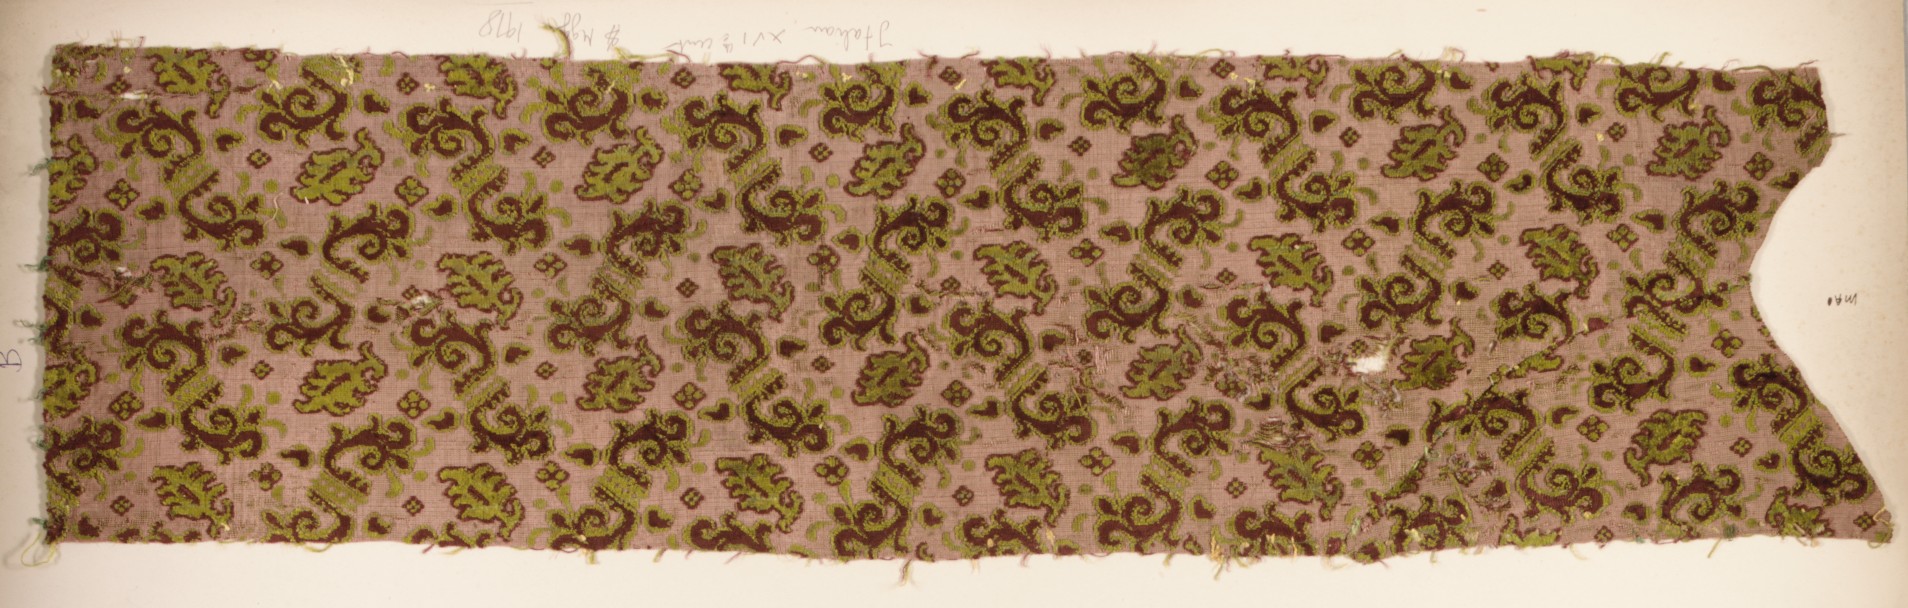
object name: fragment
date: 1501-1600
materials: silk